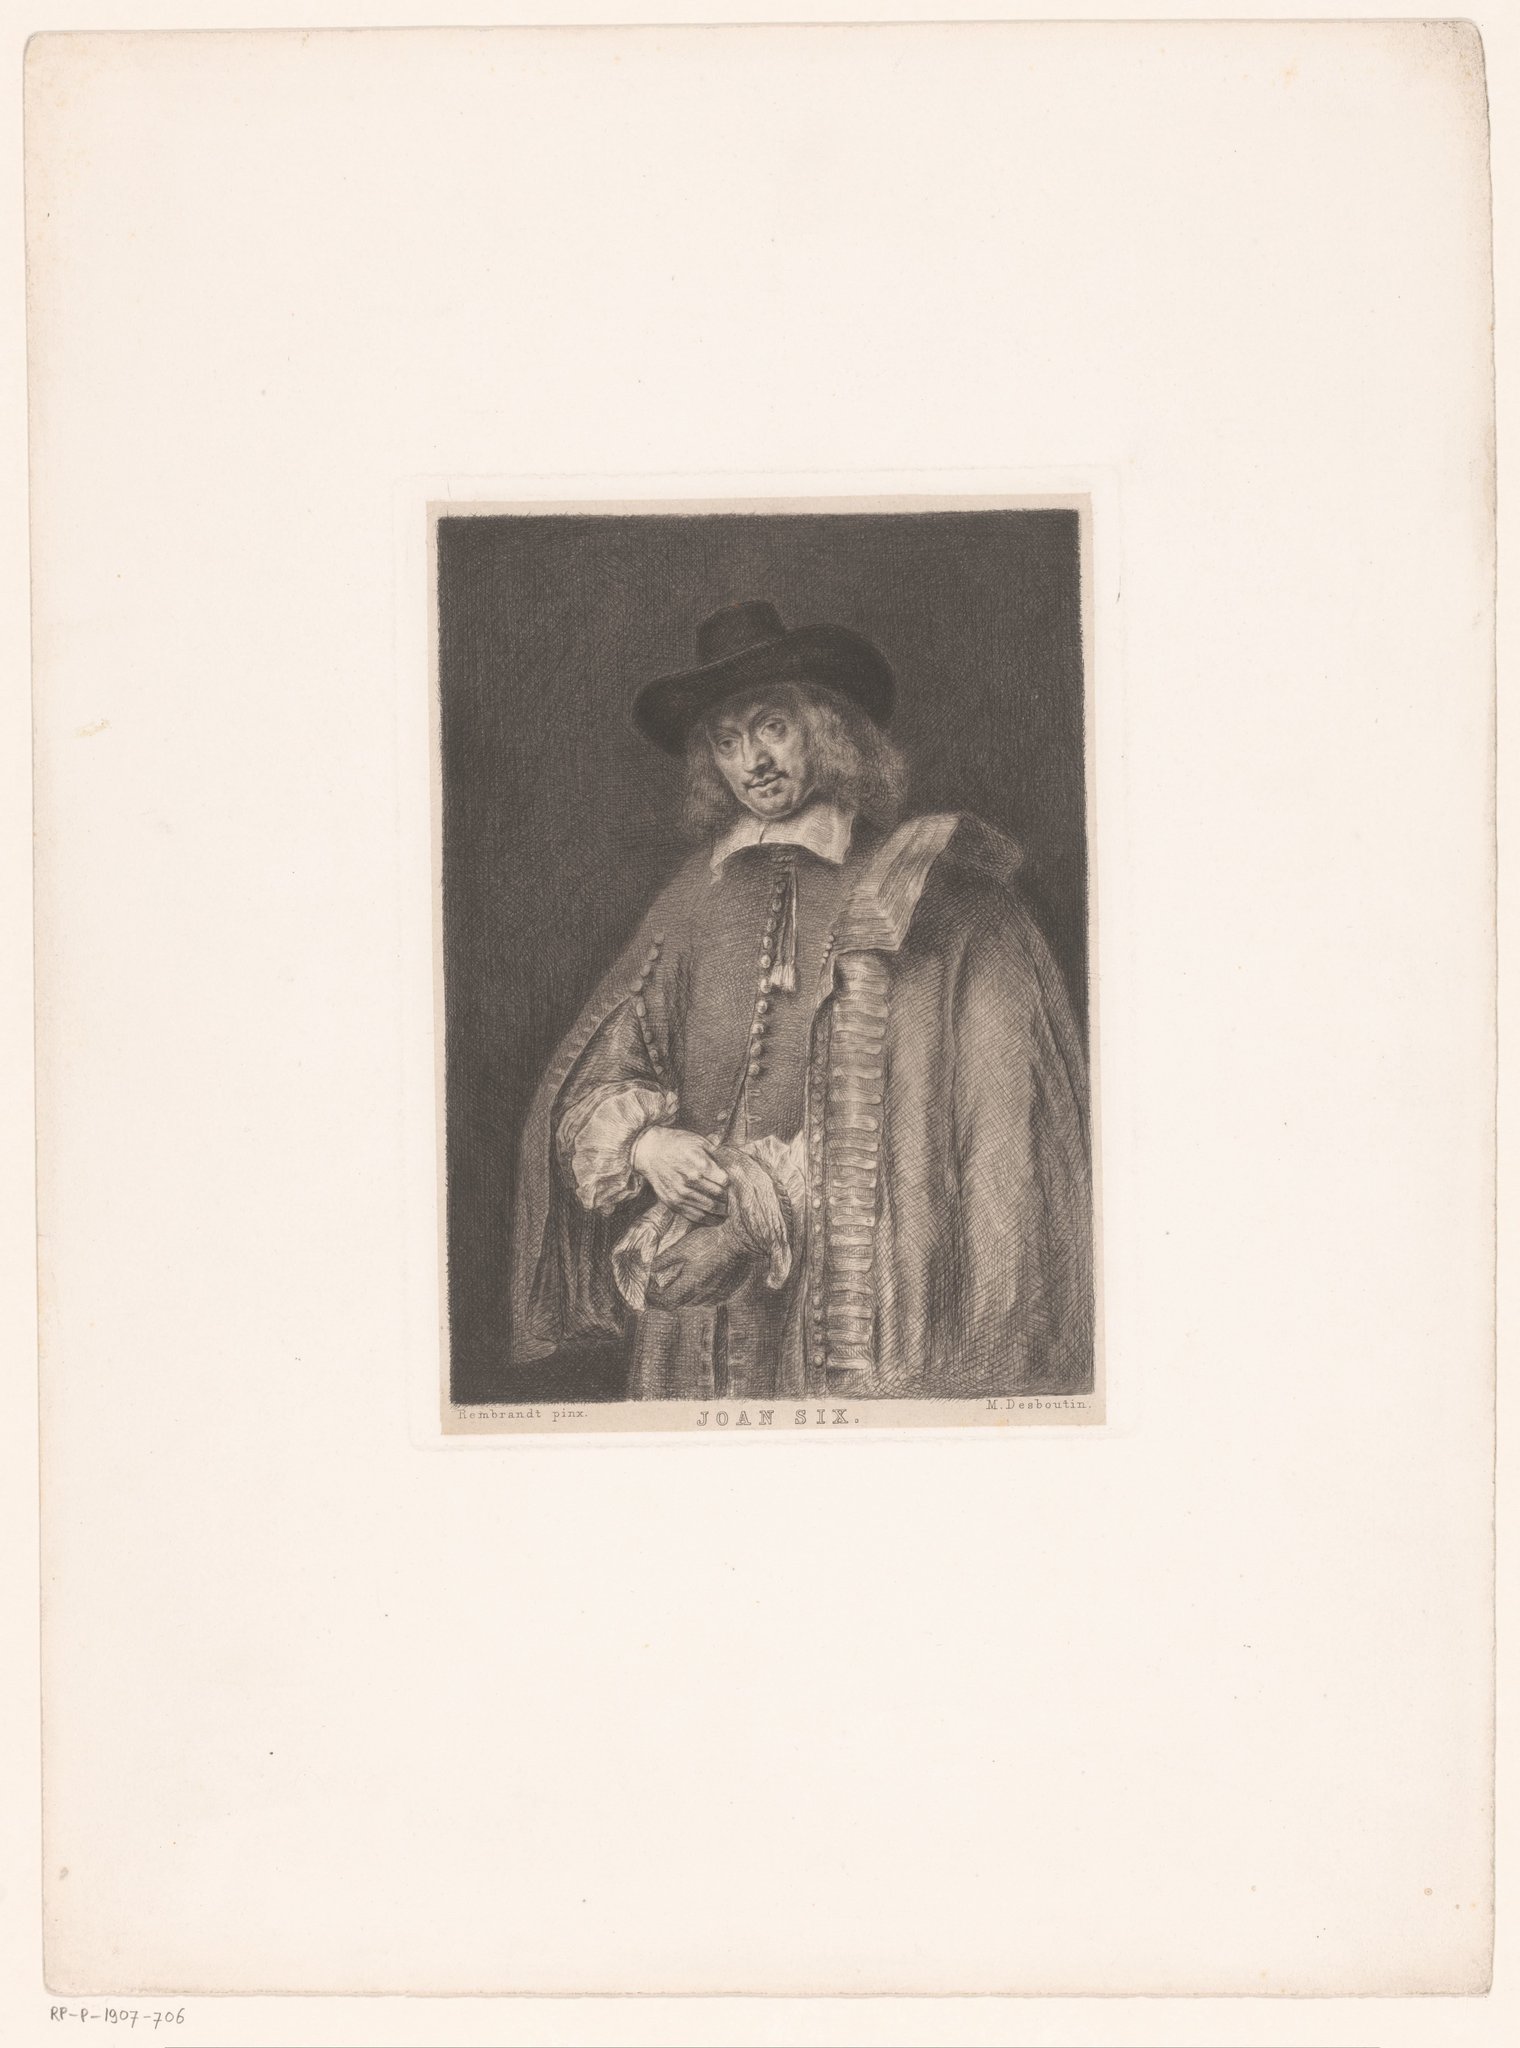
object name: print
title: Joan Six.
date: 1833-1902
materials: paper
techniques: drypoint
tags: amsterdam, mayor, jan six (1618-1700), mayor, burgomaster, historical persons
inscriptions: collector's mark: Lugt 2228